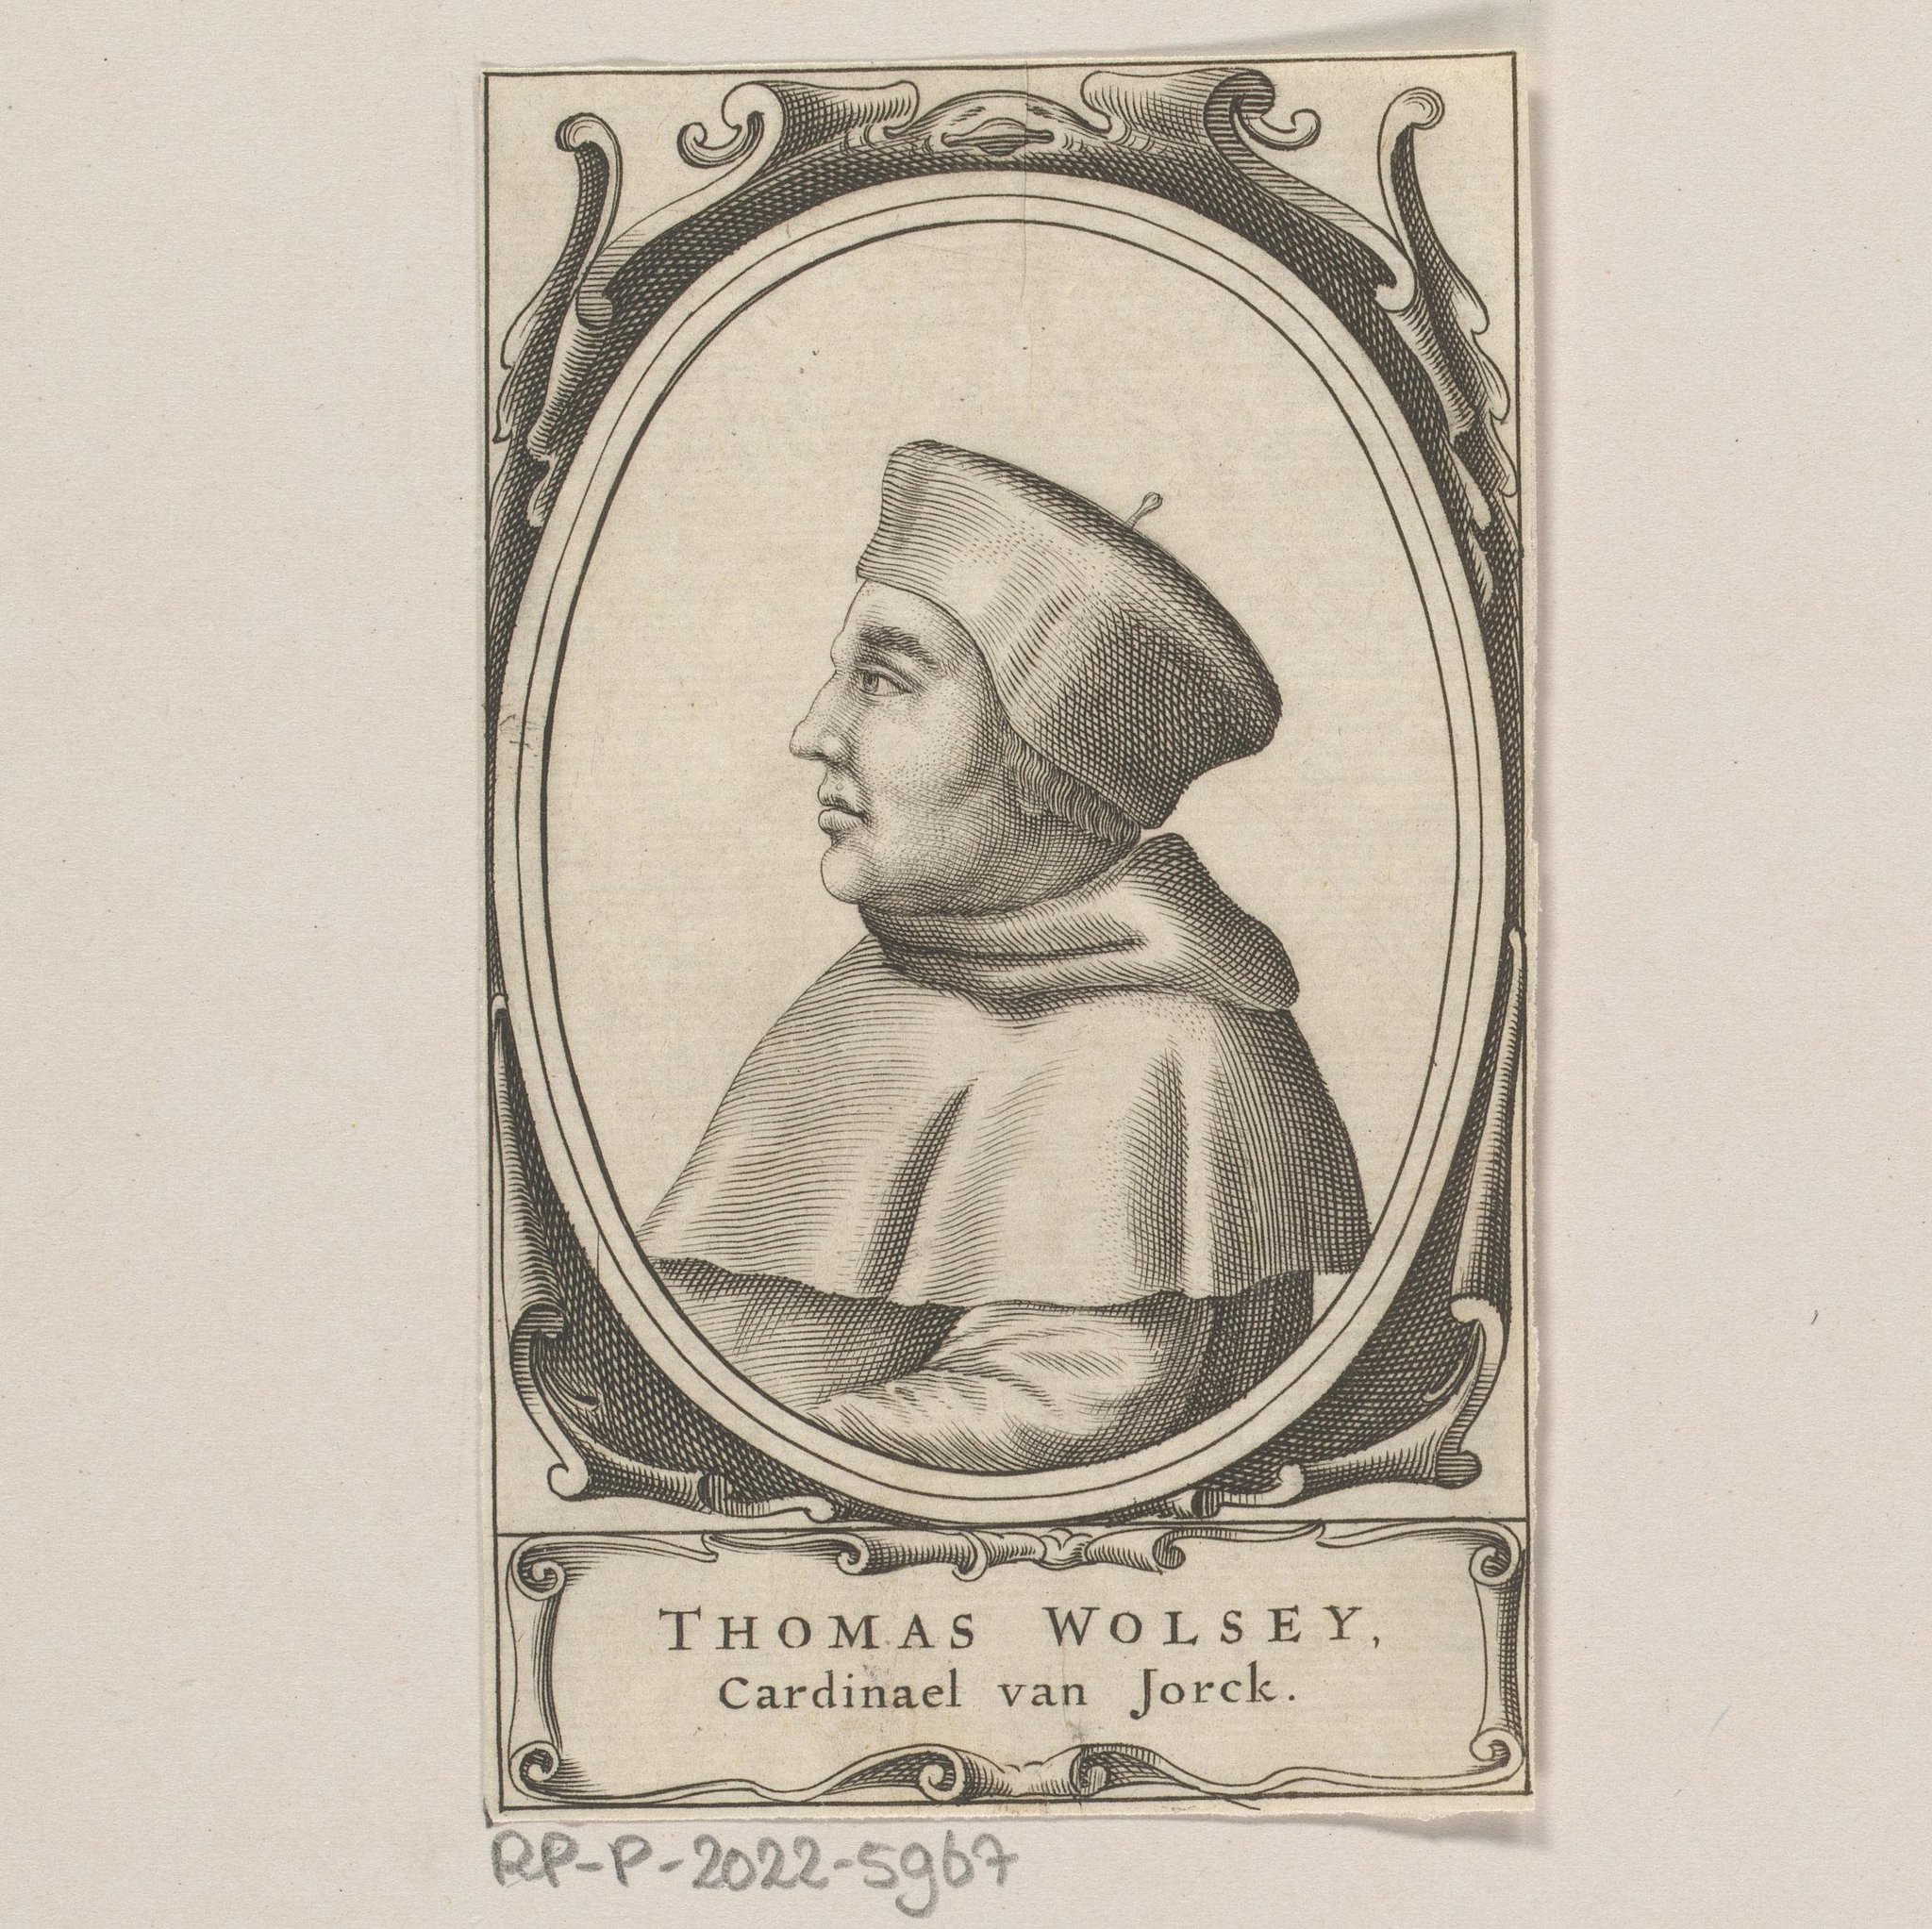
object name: print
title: Portret van Thomas Wolsey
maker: Anonymous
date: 1659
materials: paper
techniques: engraving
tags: cardinal, historical persons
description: Prent uit: Corput, Abraham van den. De goddelicke vierschare, dat is ontdeckinge der hemelsche oordelen (…). Utrecht: Johannes Janssonius van Waesberge I, 1659. Prent ook gebruikt in latere edities van dit werk.